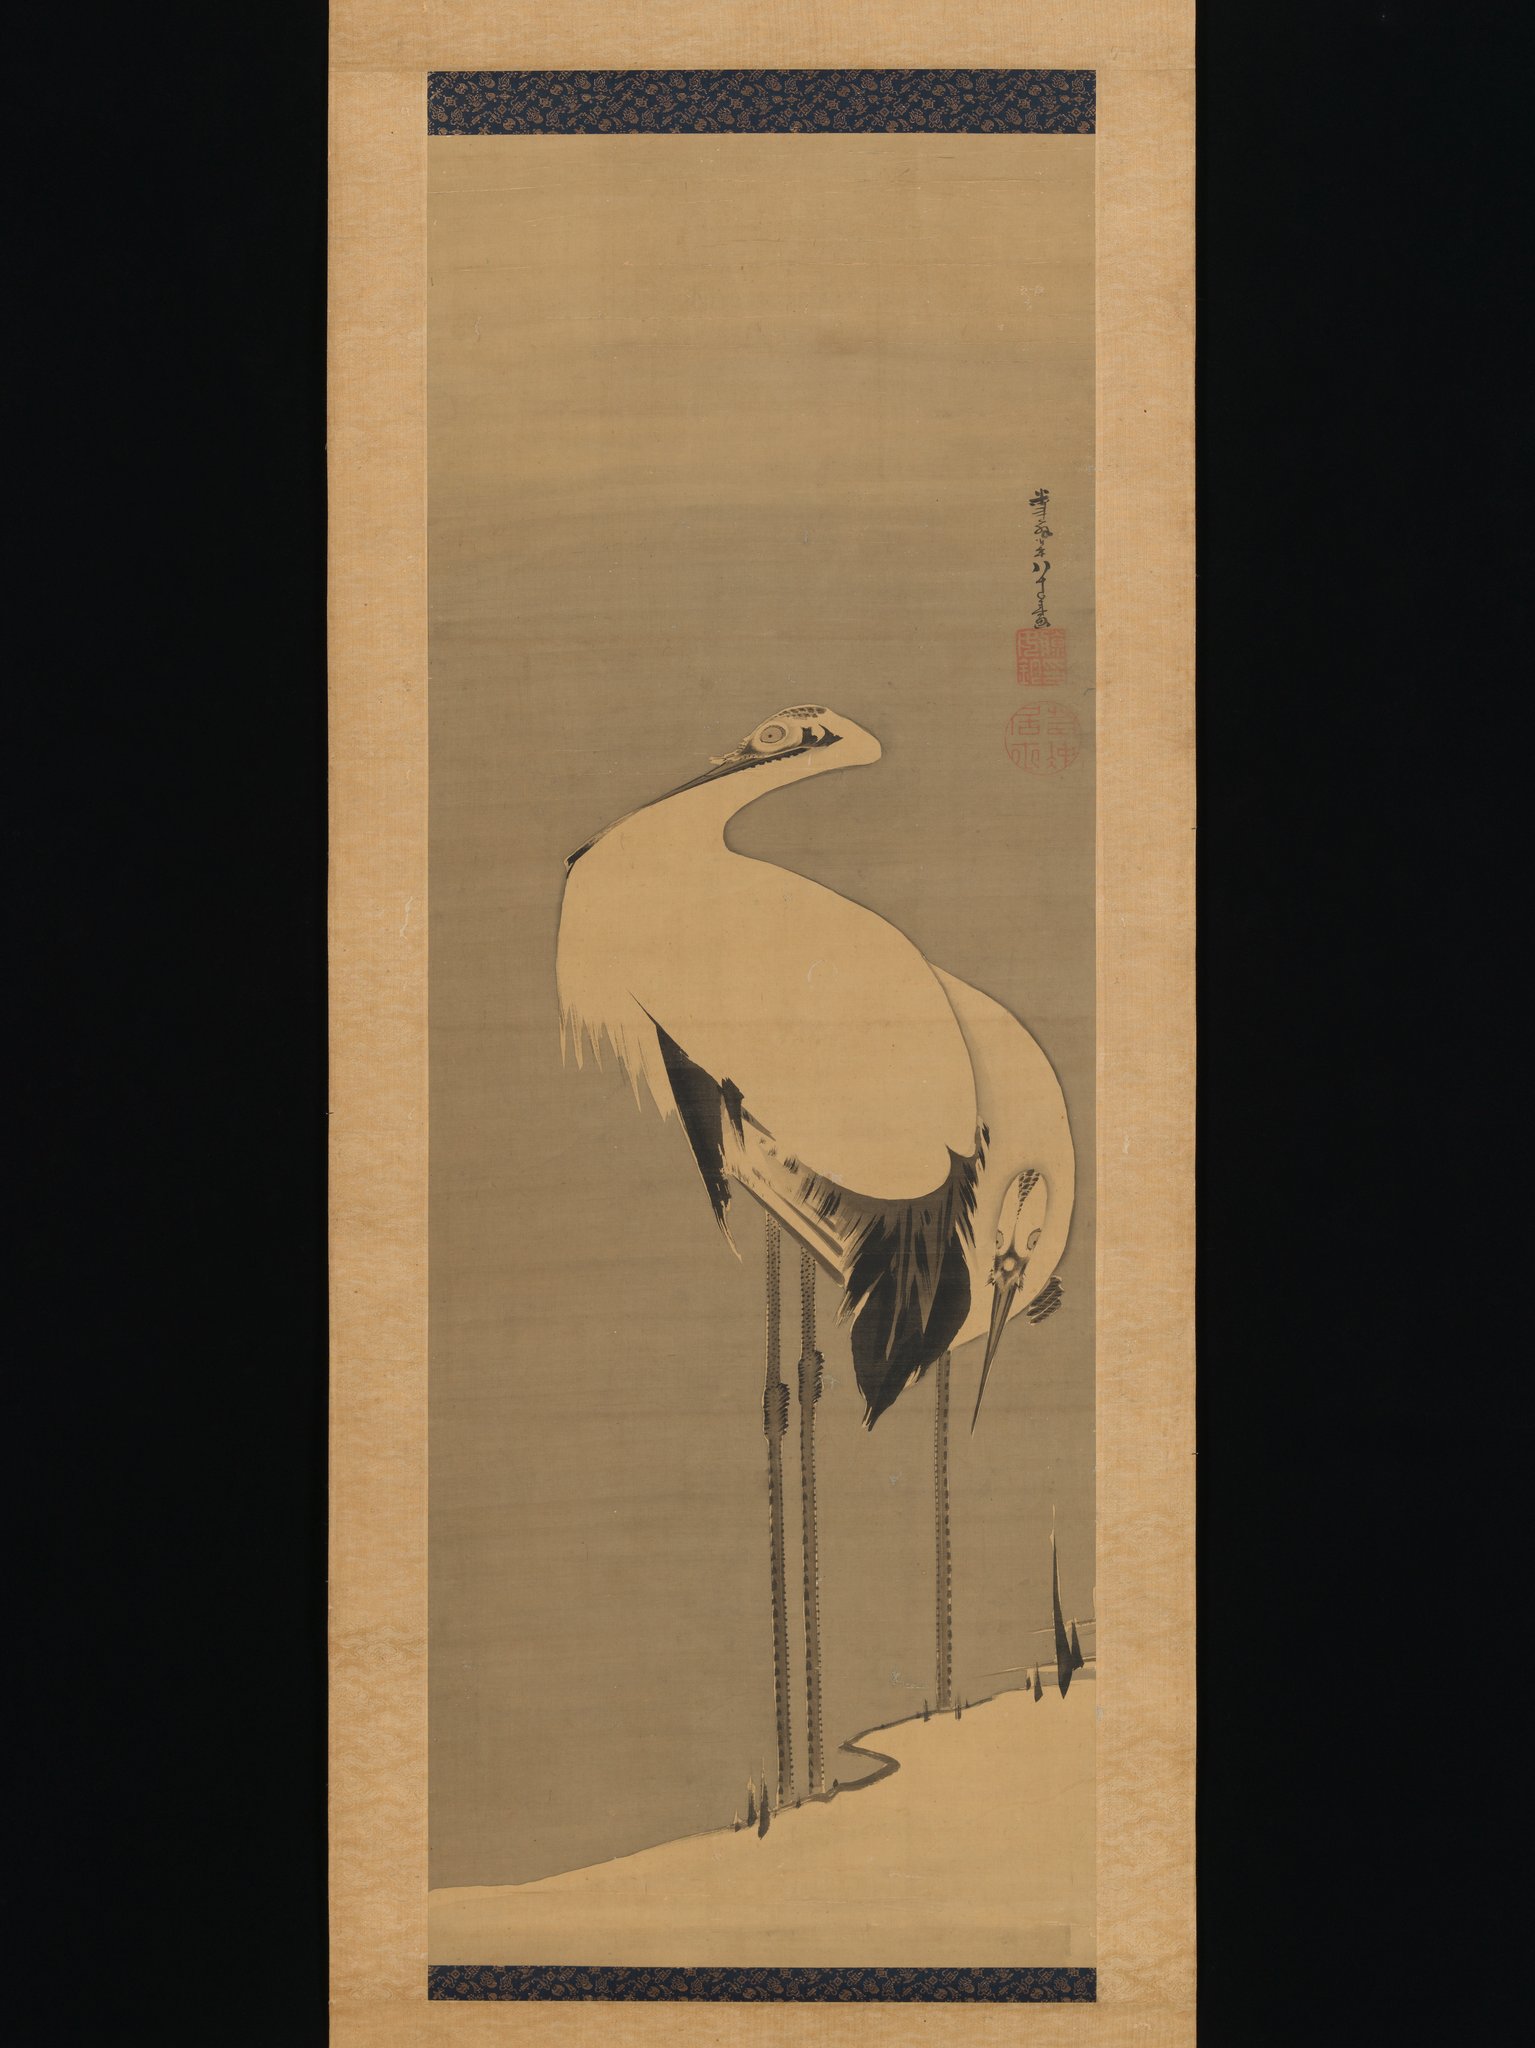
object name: hanging scroll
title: Two Cranes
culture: japanese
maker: itō jakuchū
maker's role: artist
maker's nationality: japanese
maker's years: 1716-1800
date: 1795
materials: ink, silk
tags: cranes